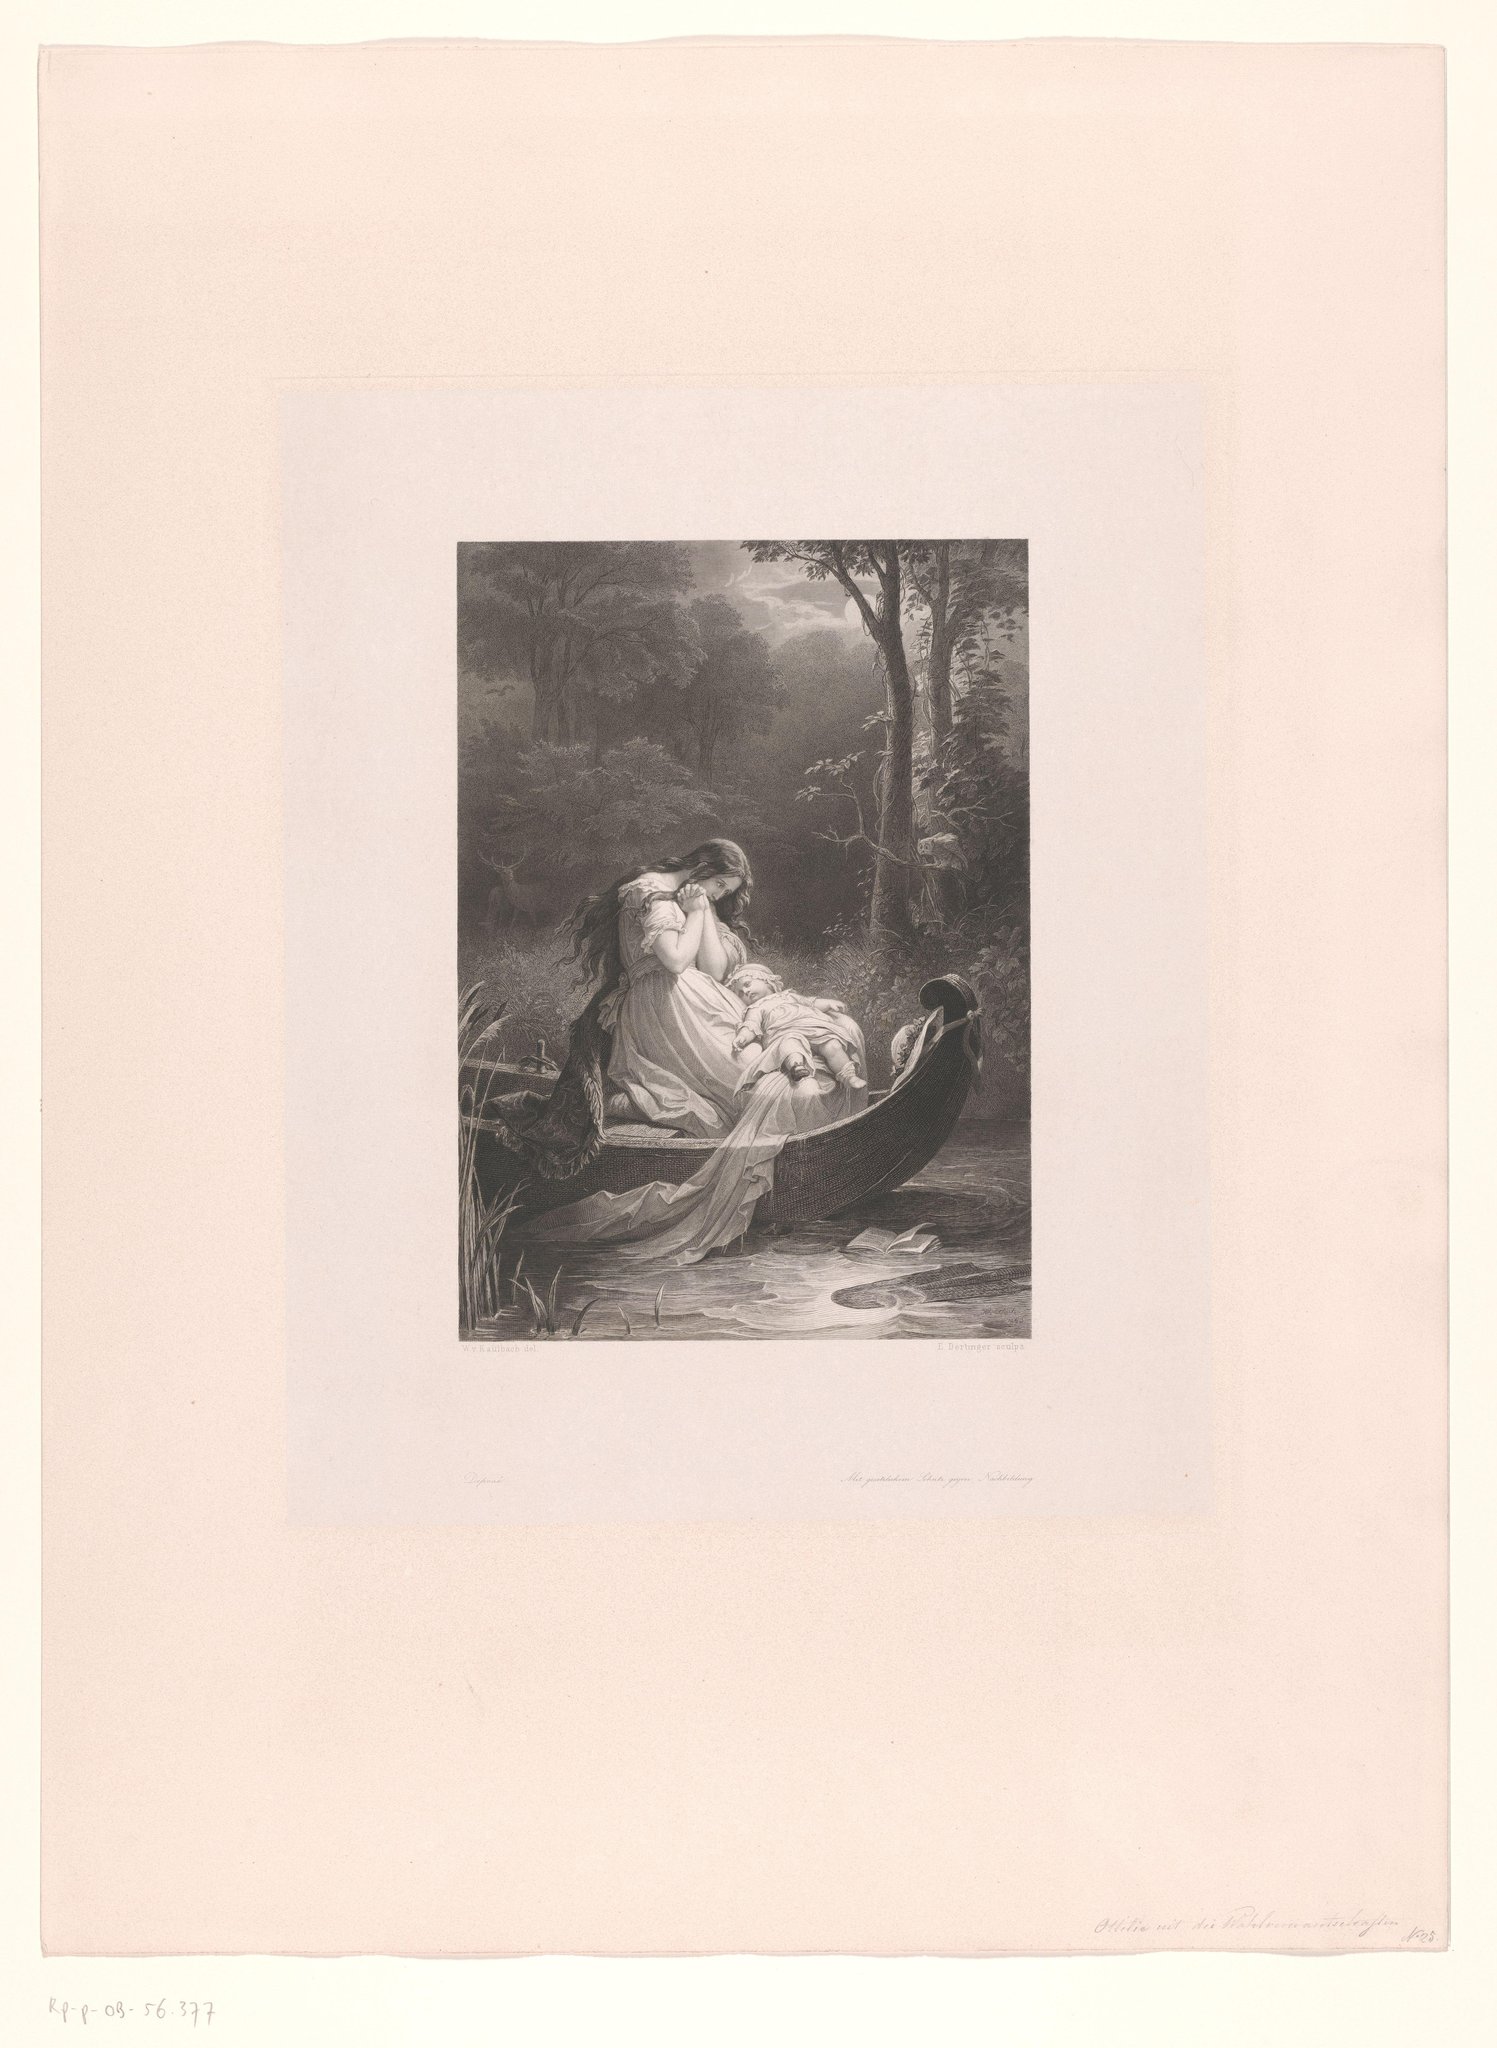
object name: print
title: Scène uit Die Wahlverwandtschaften van Johann Wolfgang von Goethe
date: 1826-1865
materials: paper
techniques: engraving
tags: draughtsman, johann wolfgang von goethe, specific works of literature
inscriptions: collector's mark: Lugt 2228